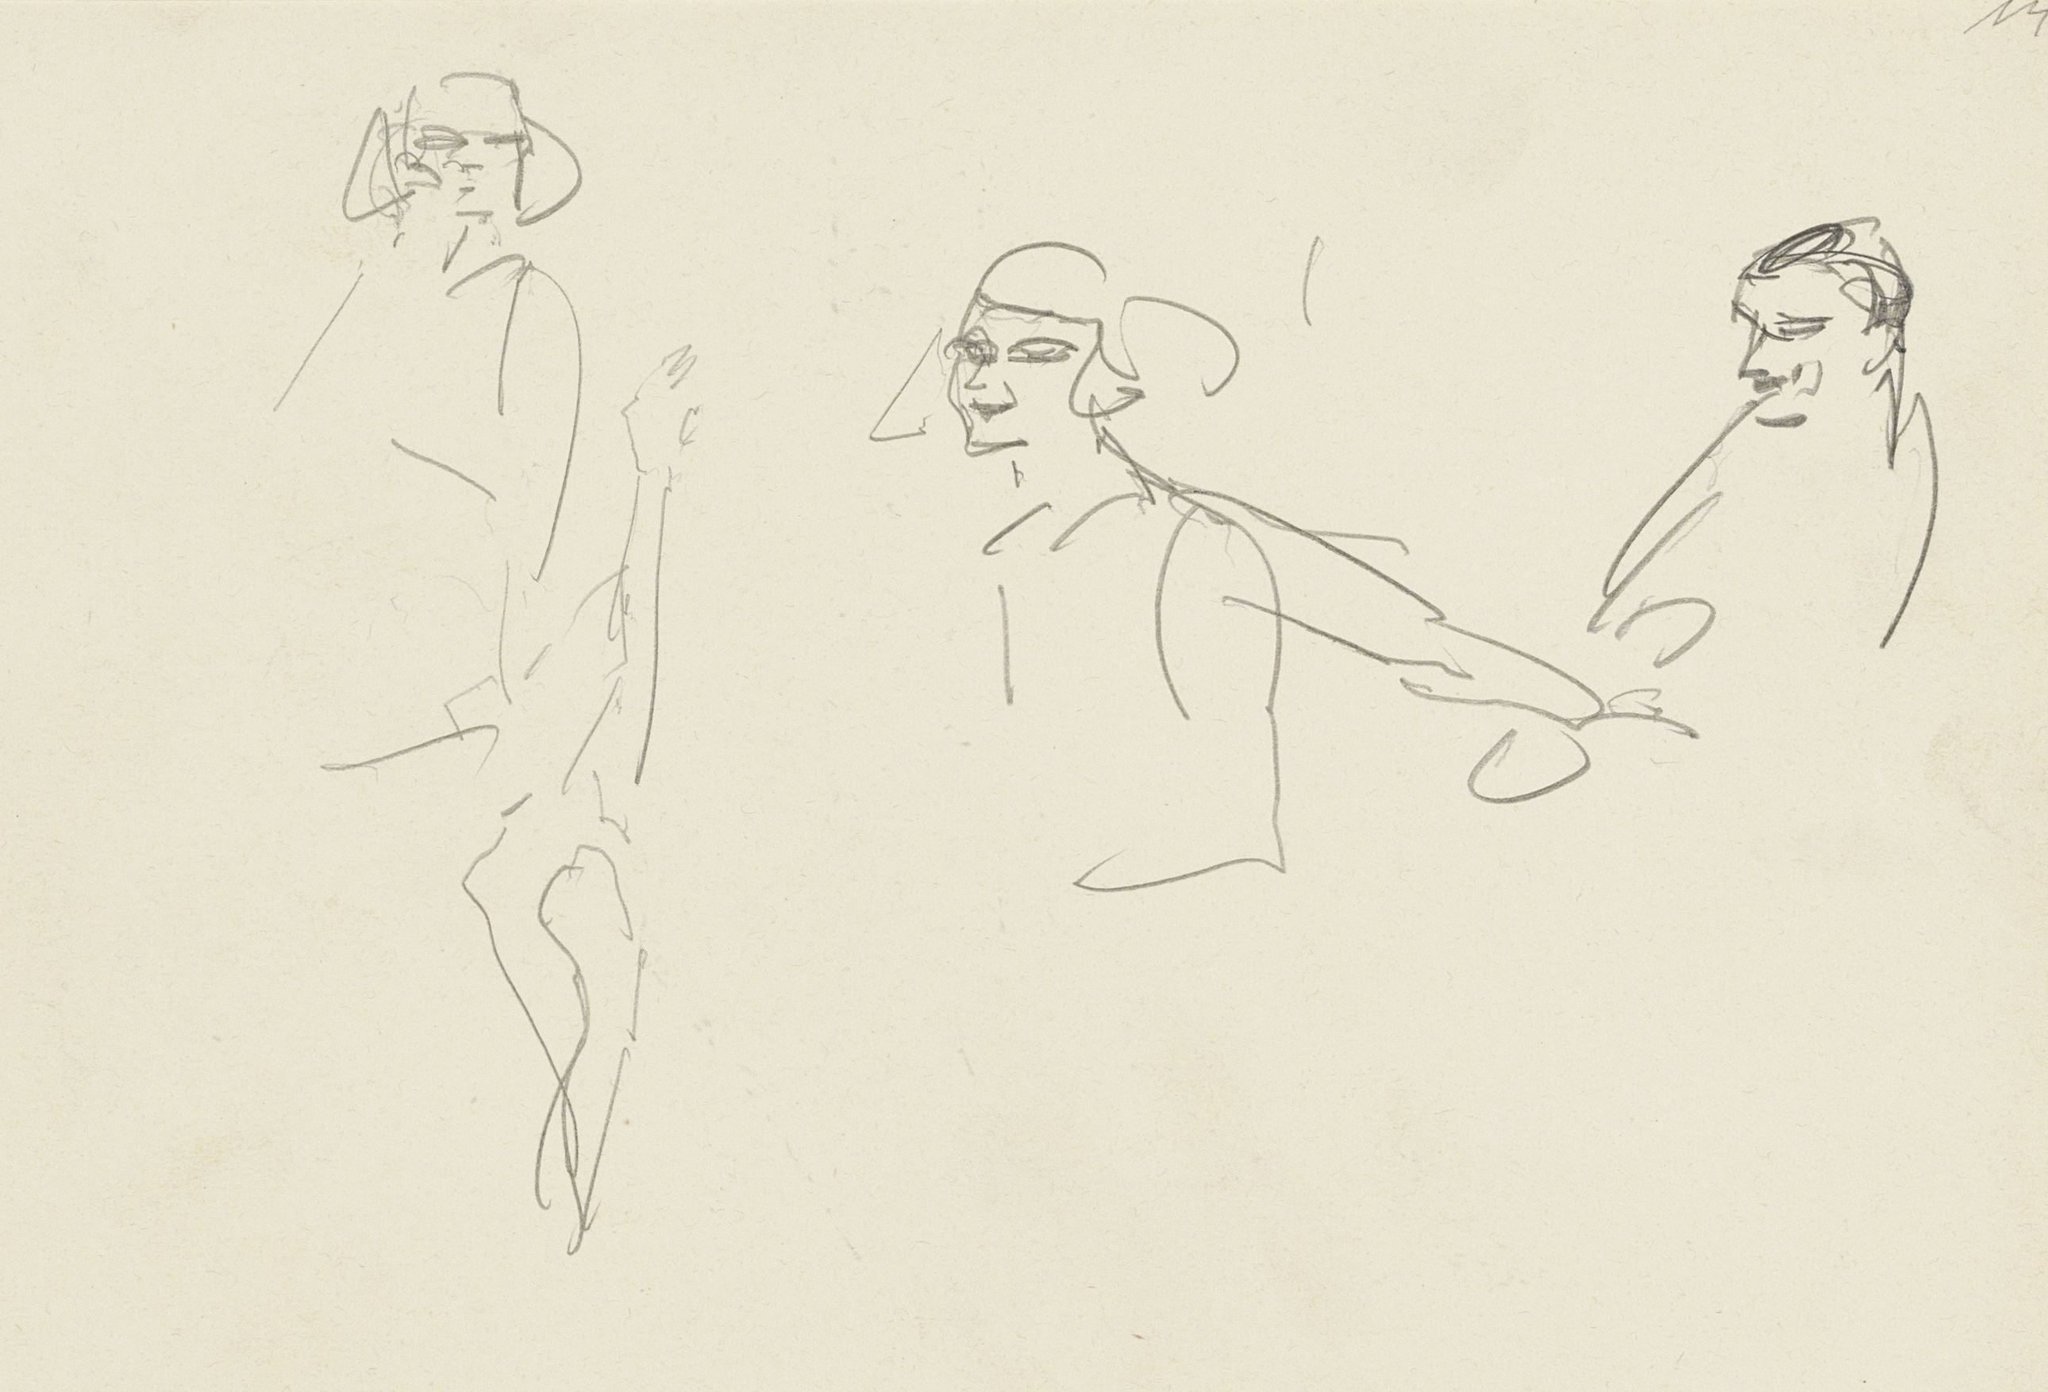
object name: sketchbook leaf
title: Figuurstudies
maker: isaac israels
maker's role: draughtsman, painter, print maker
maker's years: 1865-1934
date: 1875-1934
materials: paper, pencil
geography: the hague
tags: adult woman, adult man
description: Blad 14 recto uit schetsboek XXVIII met 17 bladen.